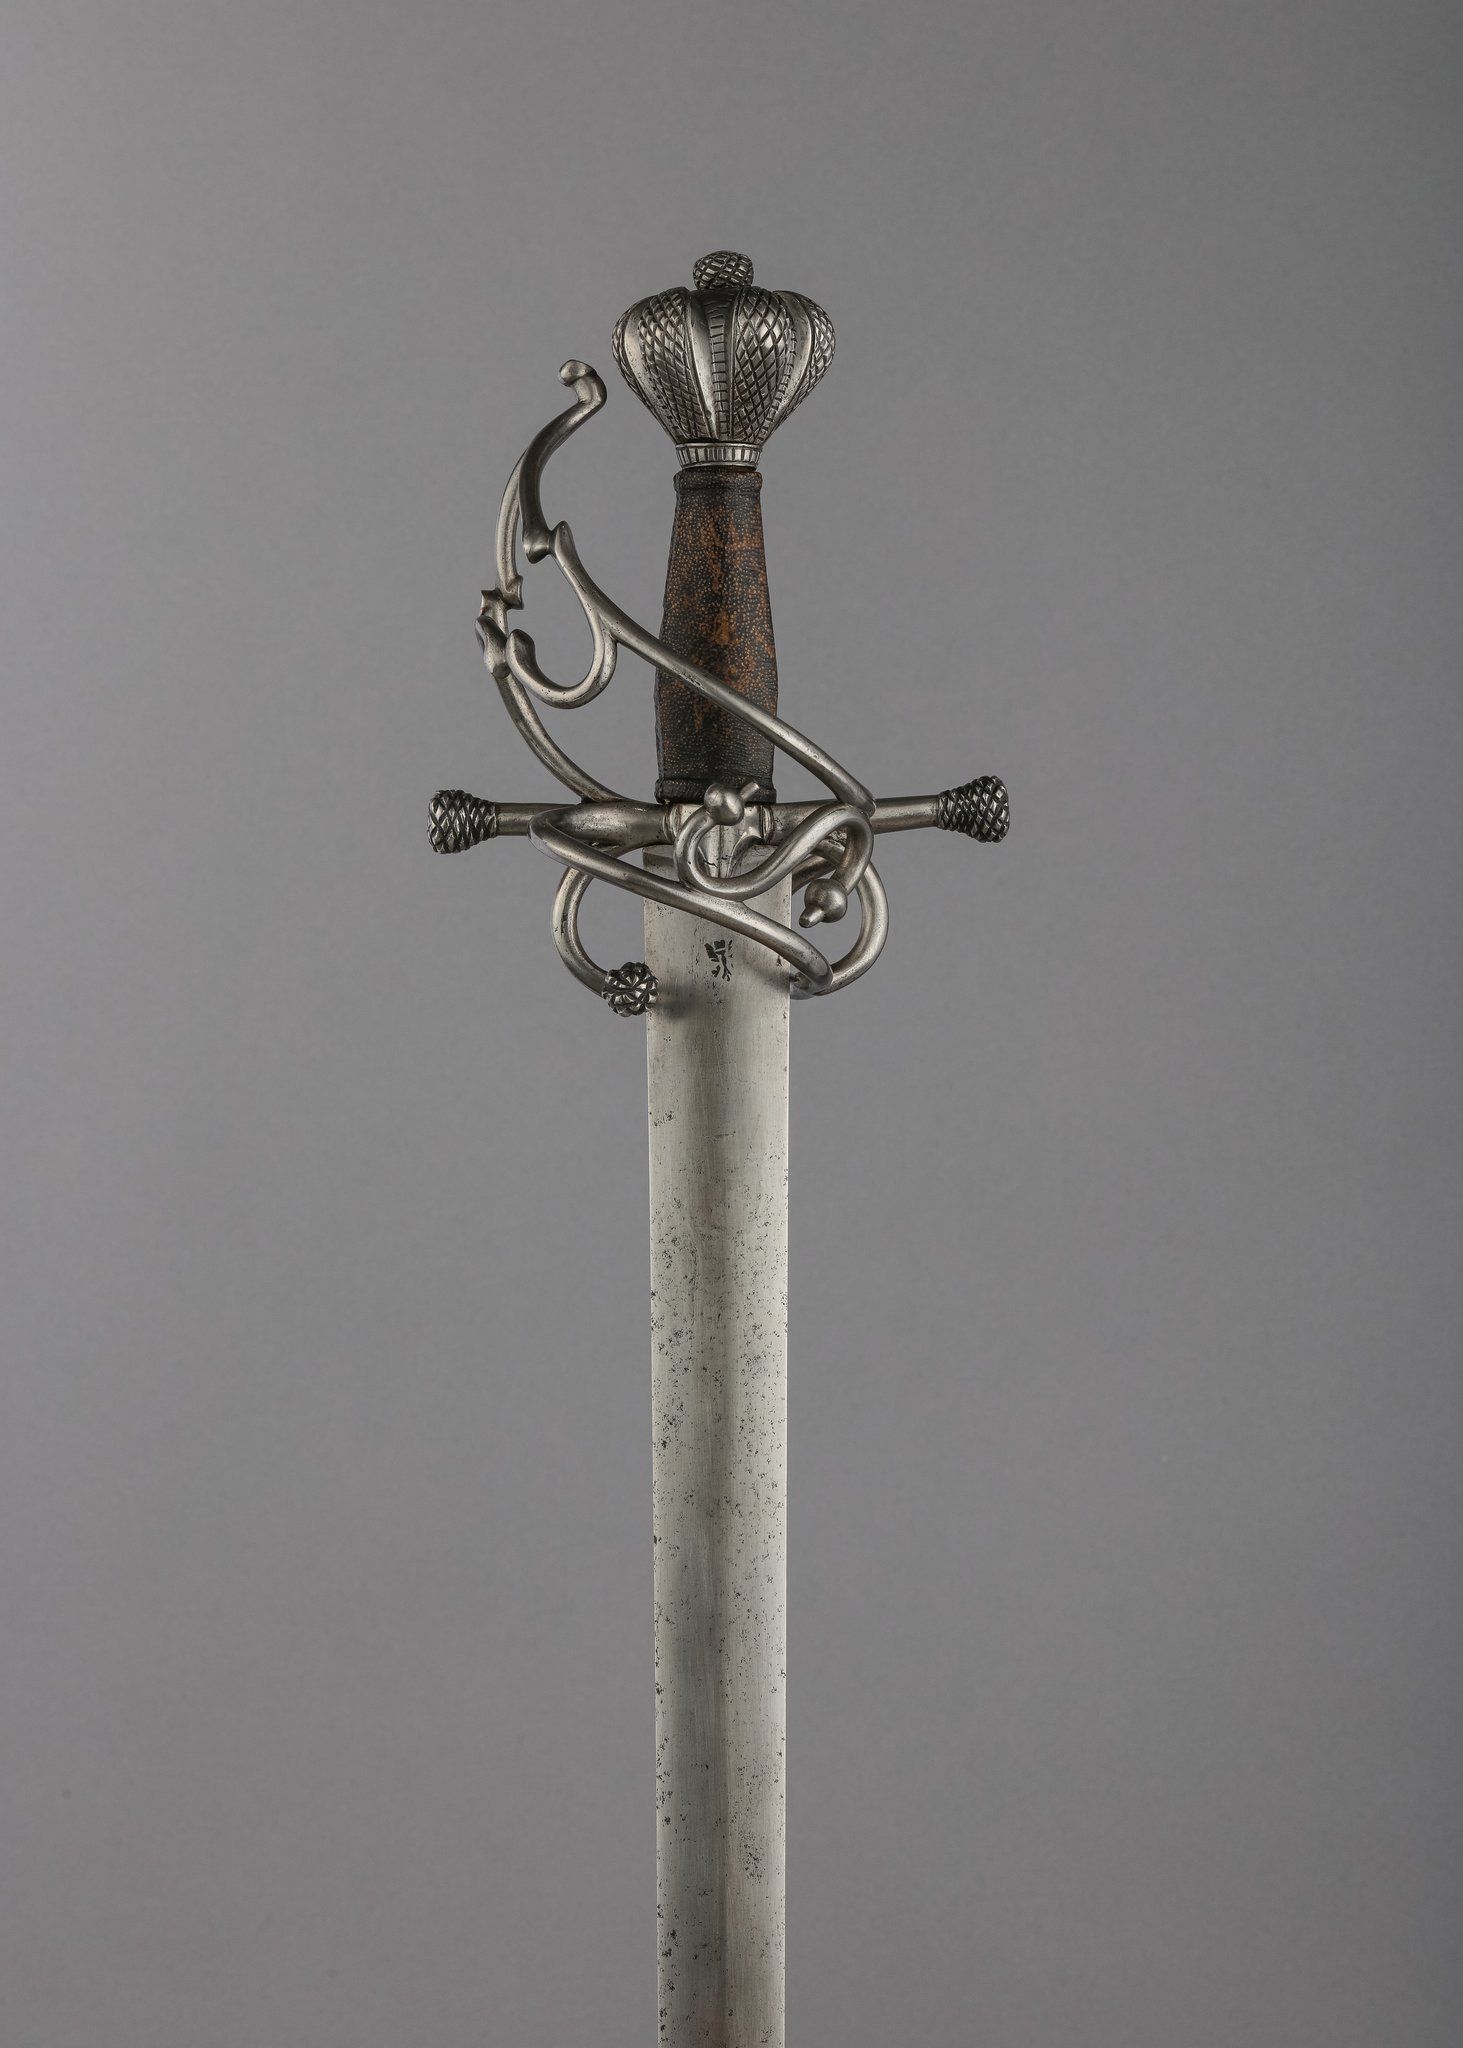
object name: broadsword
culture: german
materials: steel, wood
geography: germany